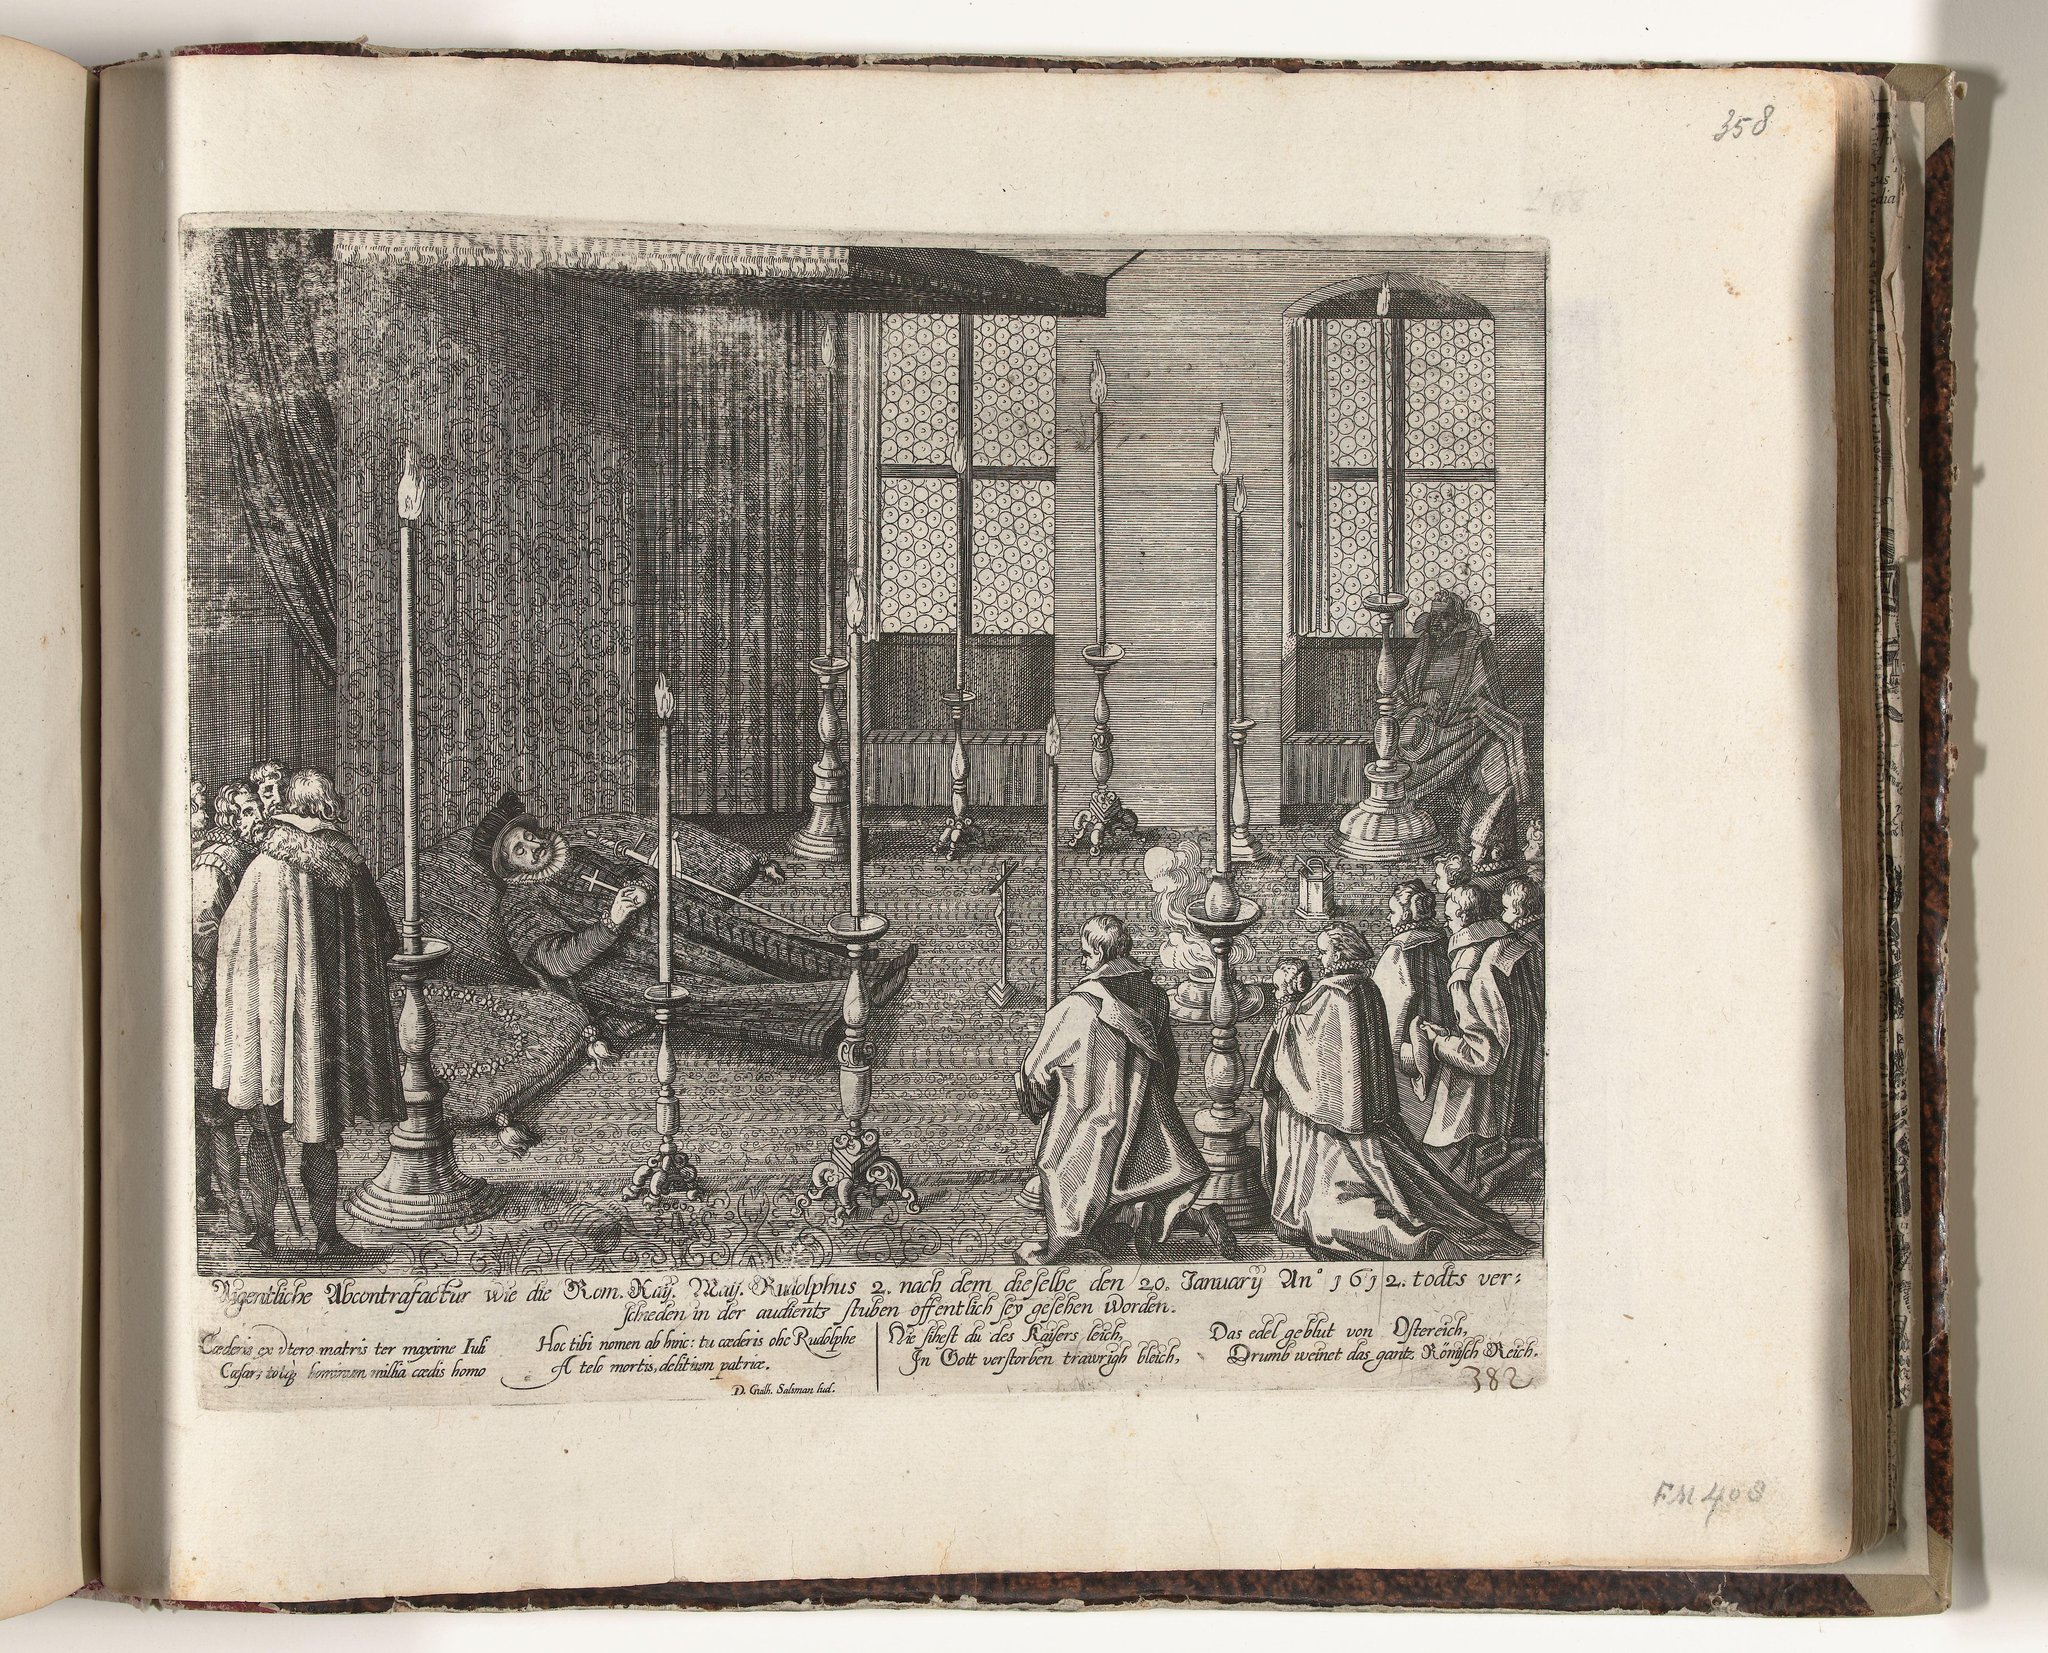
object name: print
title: Keizer Rudolf II op zijn praalbed, 1612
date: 1612-1614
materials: paper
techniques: etching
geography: cologne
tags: vienna, rudolf ii van habsburg (duits keizer), lying in state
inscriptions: inscription: ‘381’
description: Keizer Rudolf II op zijn praalbed, 20 januari 1612. De overleden keizer opgebaard op kussens op de grond. Om het bed brandende kaarsen en knielende familieleden of bezoekers. Met onderschrift van 4 regels in het Latijn en 4 regels in het Duits. Rechtsonder met pen genummerd: 382. De prent maakt deel uit van een album.